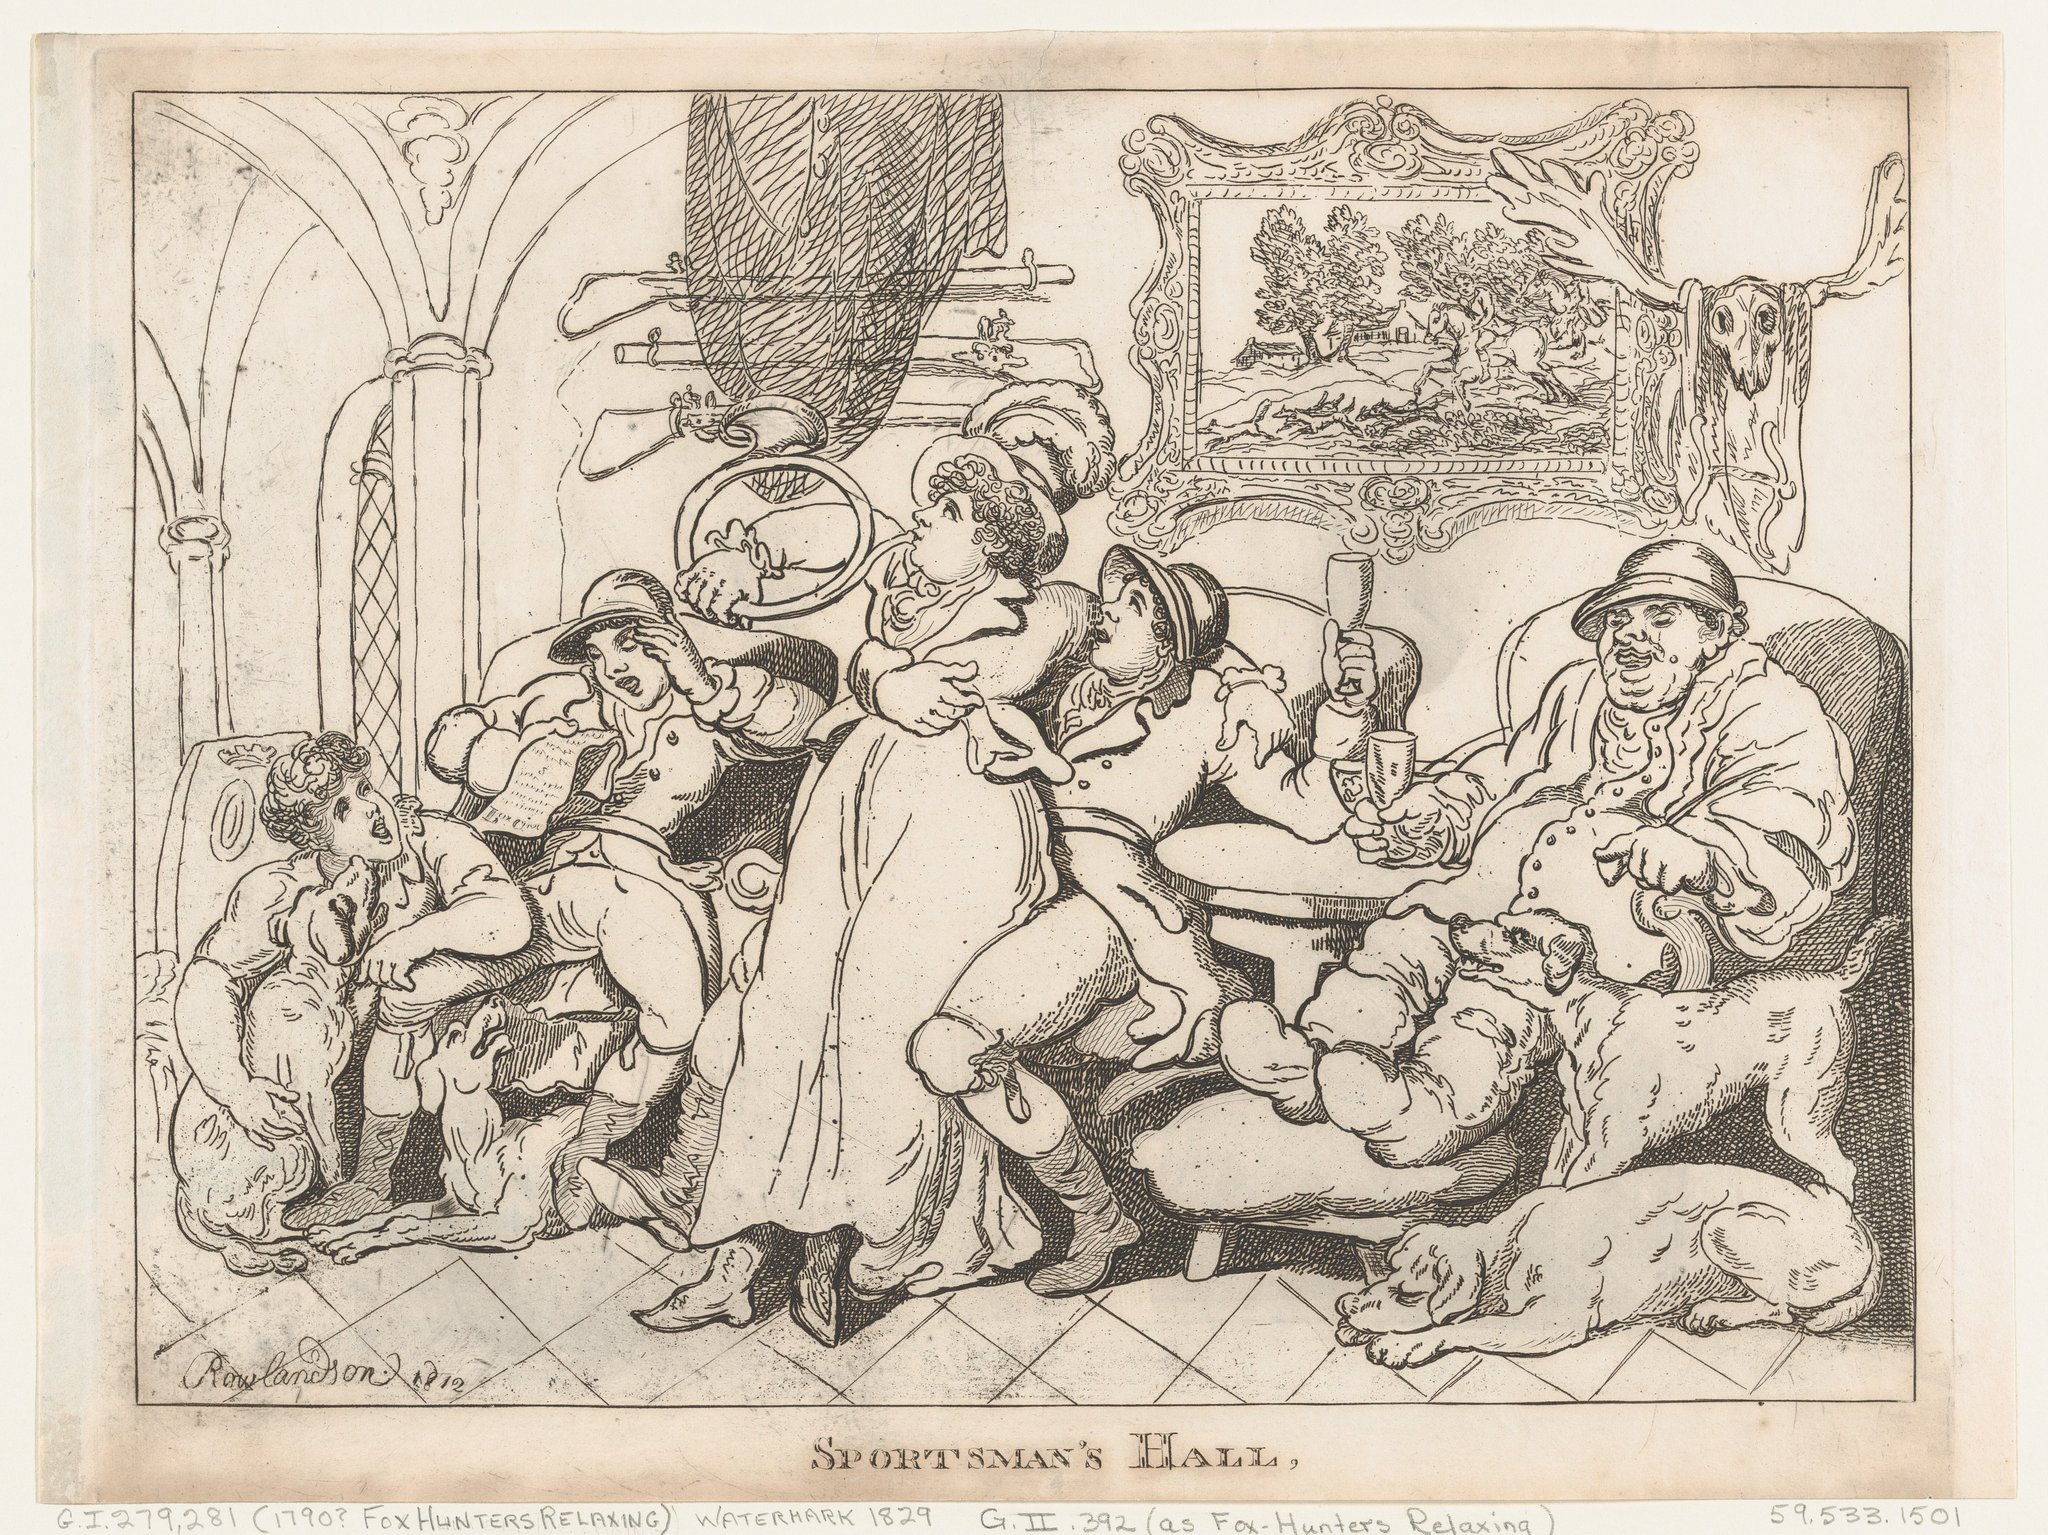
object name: print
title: Sportsman's Hall, or Fox-Hunters Relaxing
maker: thomas rowlandson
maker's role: artist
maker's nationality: british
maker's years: 1757-1827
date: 1812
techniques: etching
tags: men,women,dogs,drinking